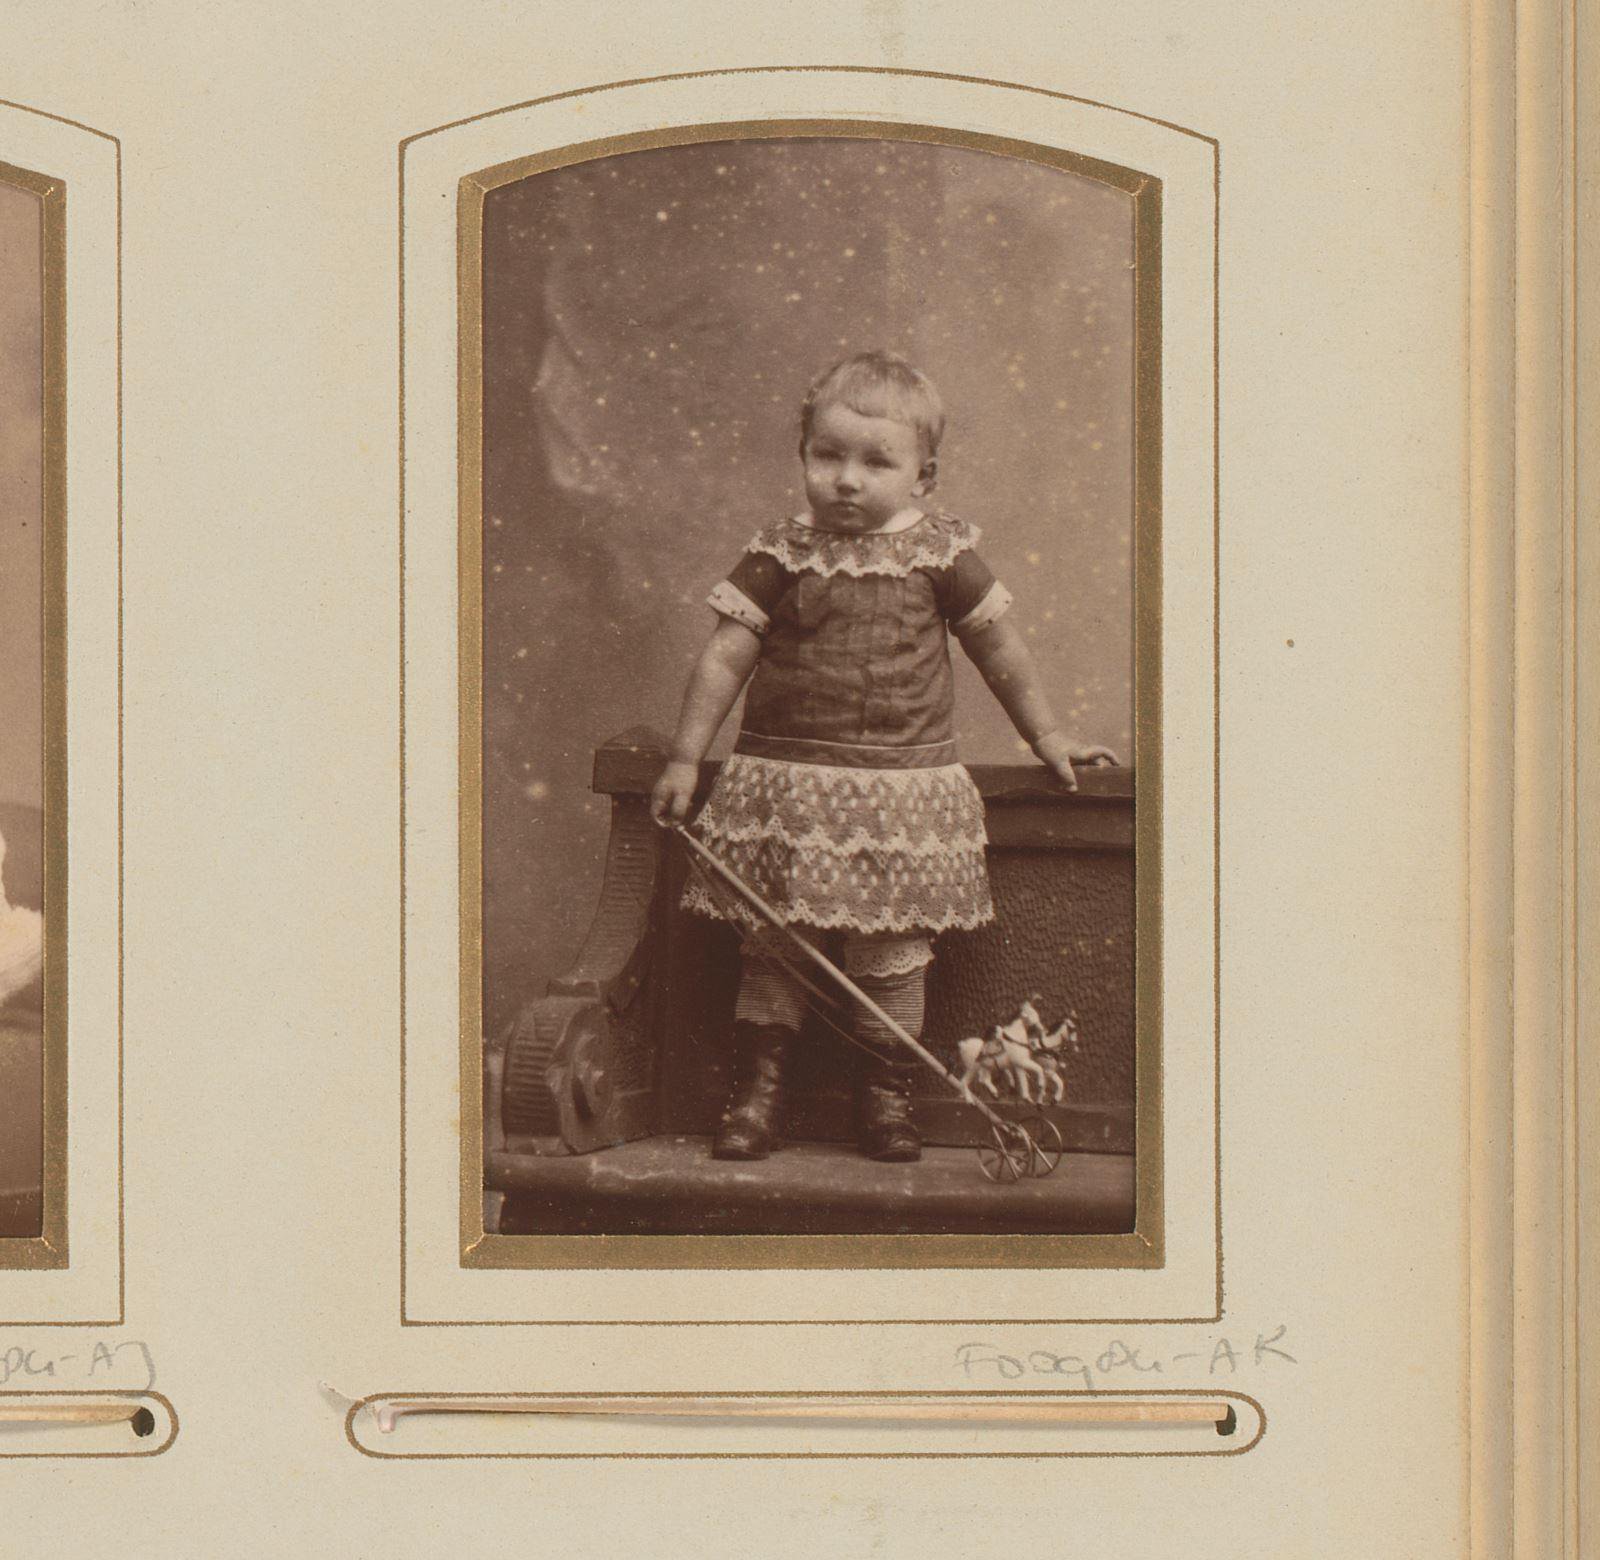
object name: carte de visite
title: Portret van een staand meisje met stuk speelgoed in de hand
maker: b.j. pottjewijd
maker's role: fotograaf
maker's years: 1859-1941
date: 1880-1900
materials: cardboard, photographic support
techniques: albumen print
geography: winschoten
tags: historical persons - bb - woman, (playing with) toy animals, toddler (female)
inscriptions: inscription: ‘B.J. Pottjewijd/ Winschoten./ Het negatief blijft voor/ nabestelling bewaard./ Vergrootingen in alle afmetingen.’